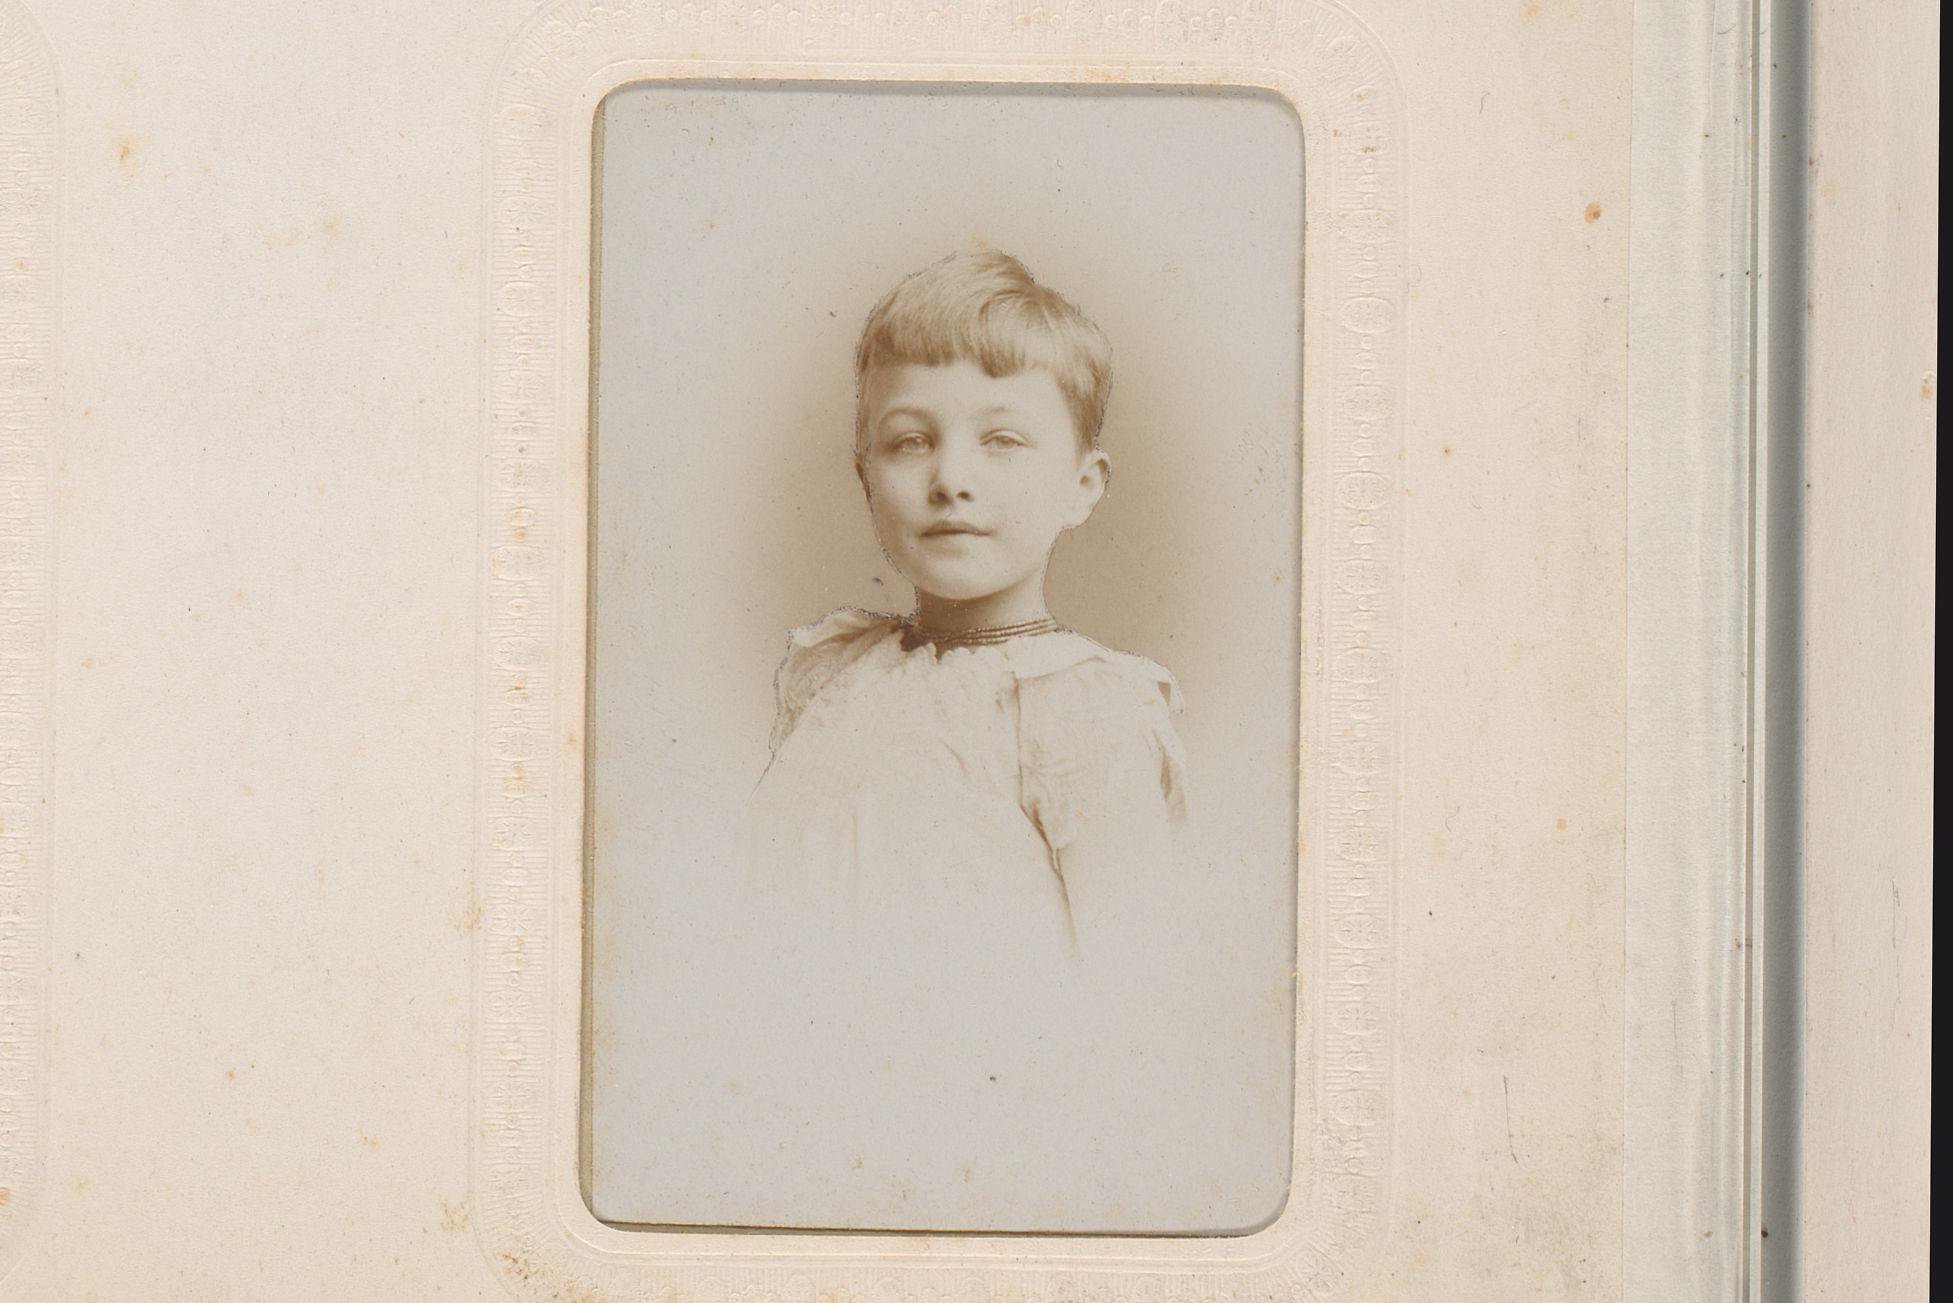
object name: photograph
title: Portret van een zittend meisje met stukken papier in de hand, met op een grond een mand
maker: Anonymous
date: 1860-1900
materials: cardboard, photographic support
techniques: albumen print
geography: netherlands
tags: sitting figure - aa - female human figure, historical persons - bb - woman, container made of plant material other than wood: basket, toddler (female)